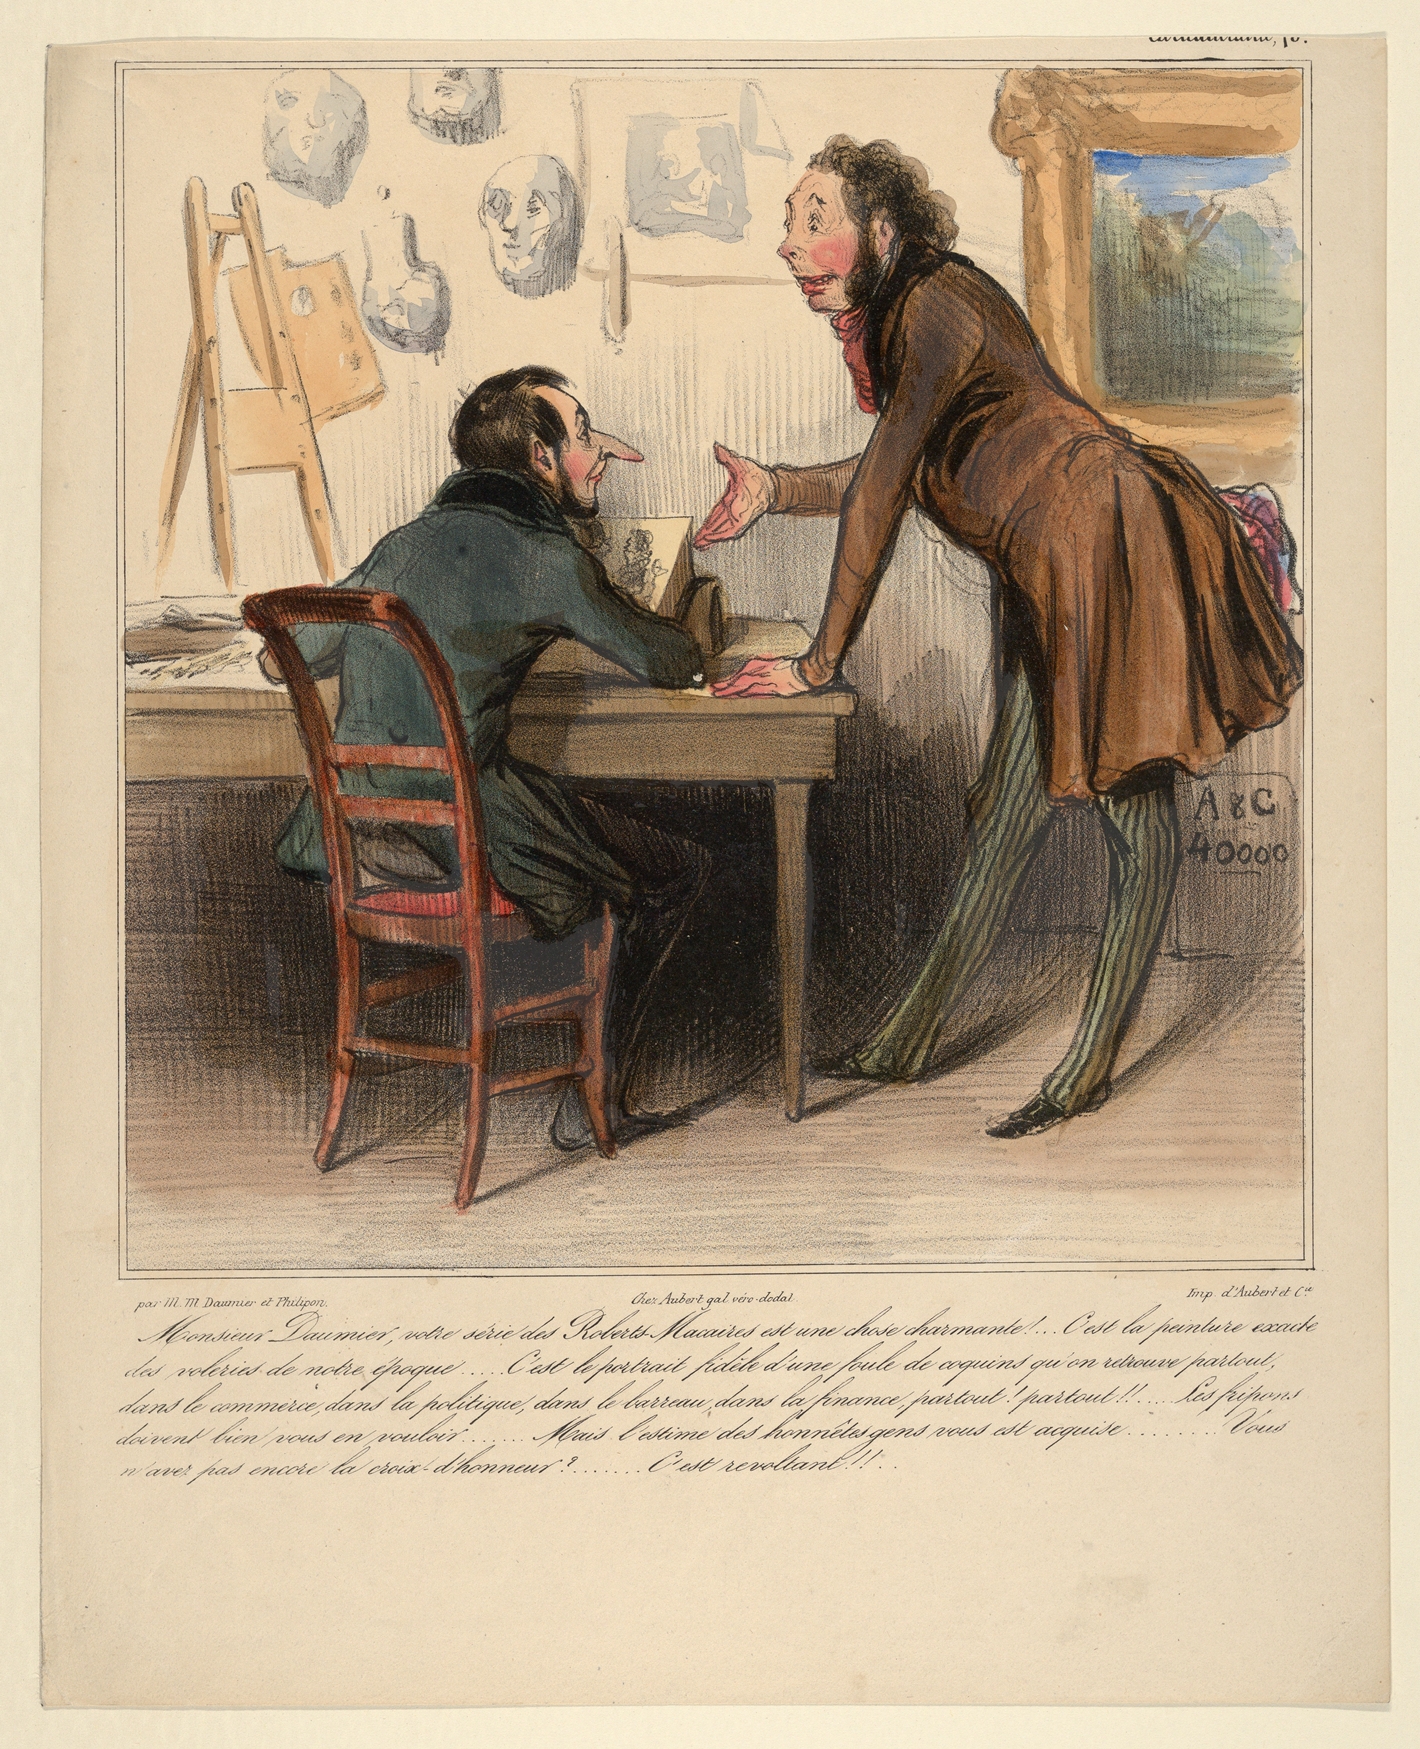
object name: print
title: Monsieur Daumier, your Robert-Macaire series is delightful (...), from "Caricaturana"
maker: honoré daumier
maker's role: artist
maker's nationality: french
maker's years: 1808-1879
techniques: coloring, lithograph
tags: men